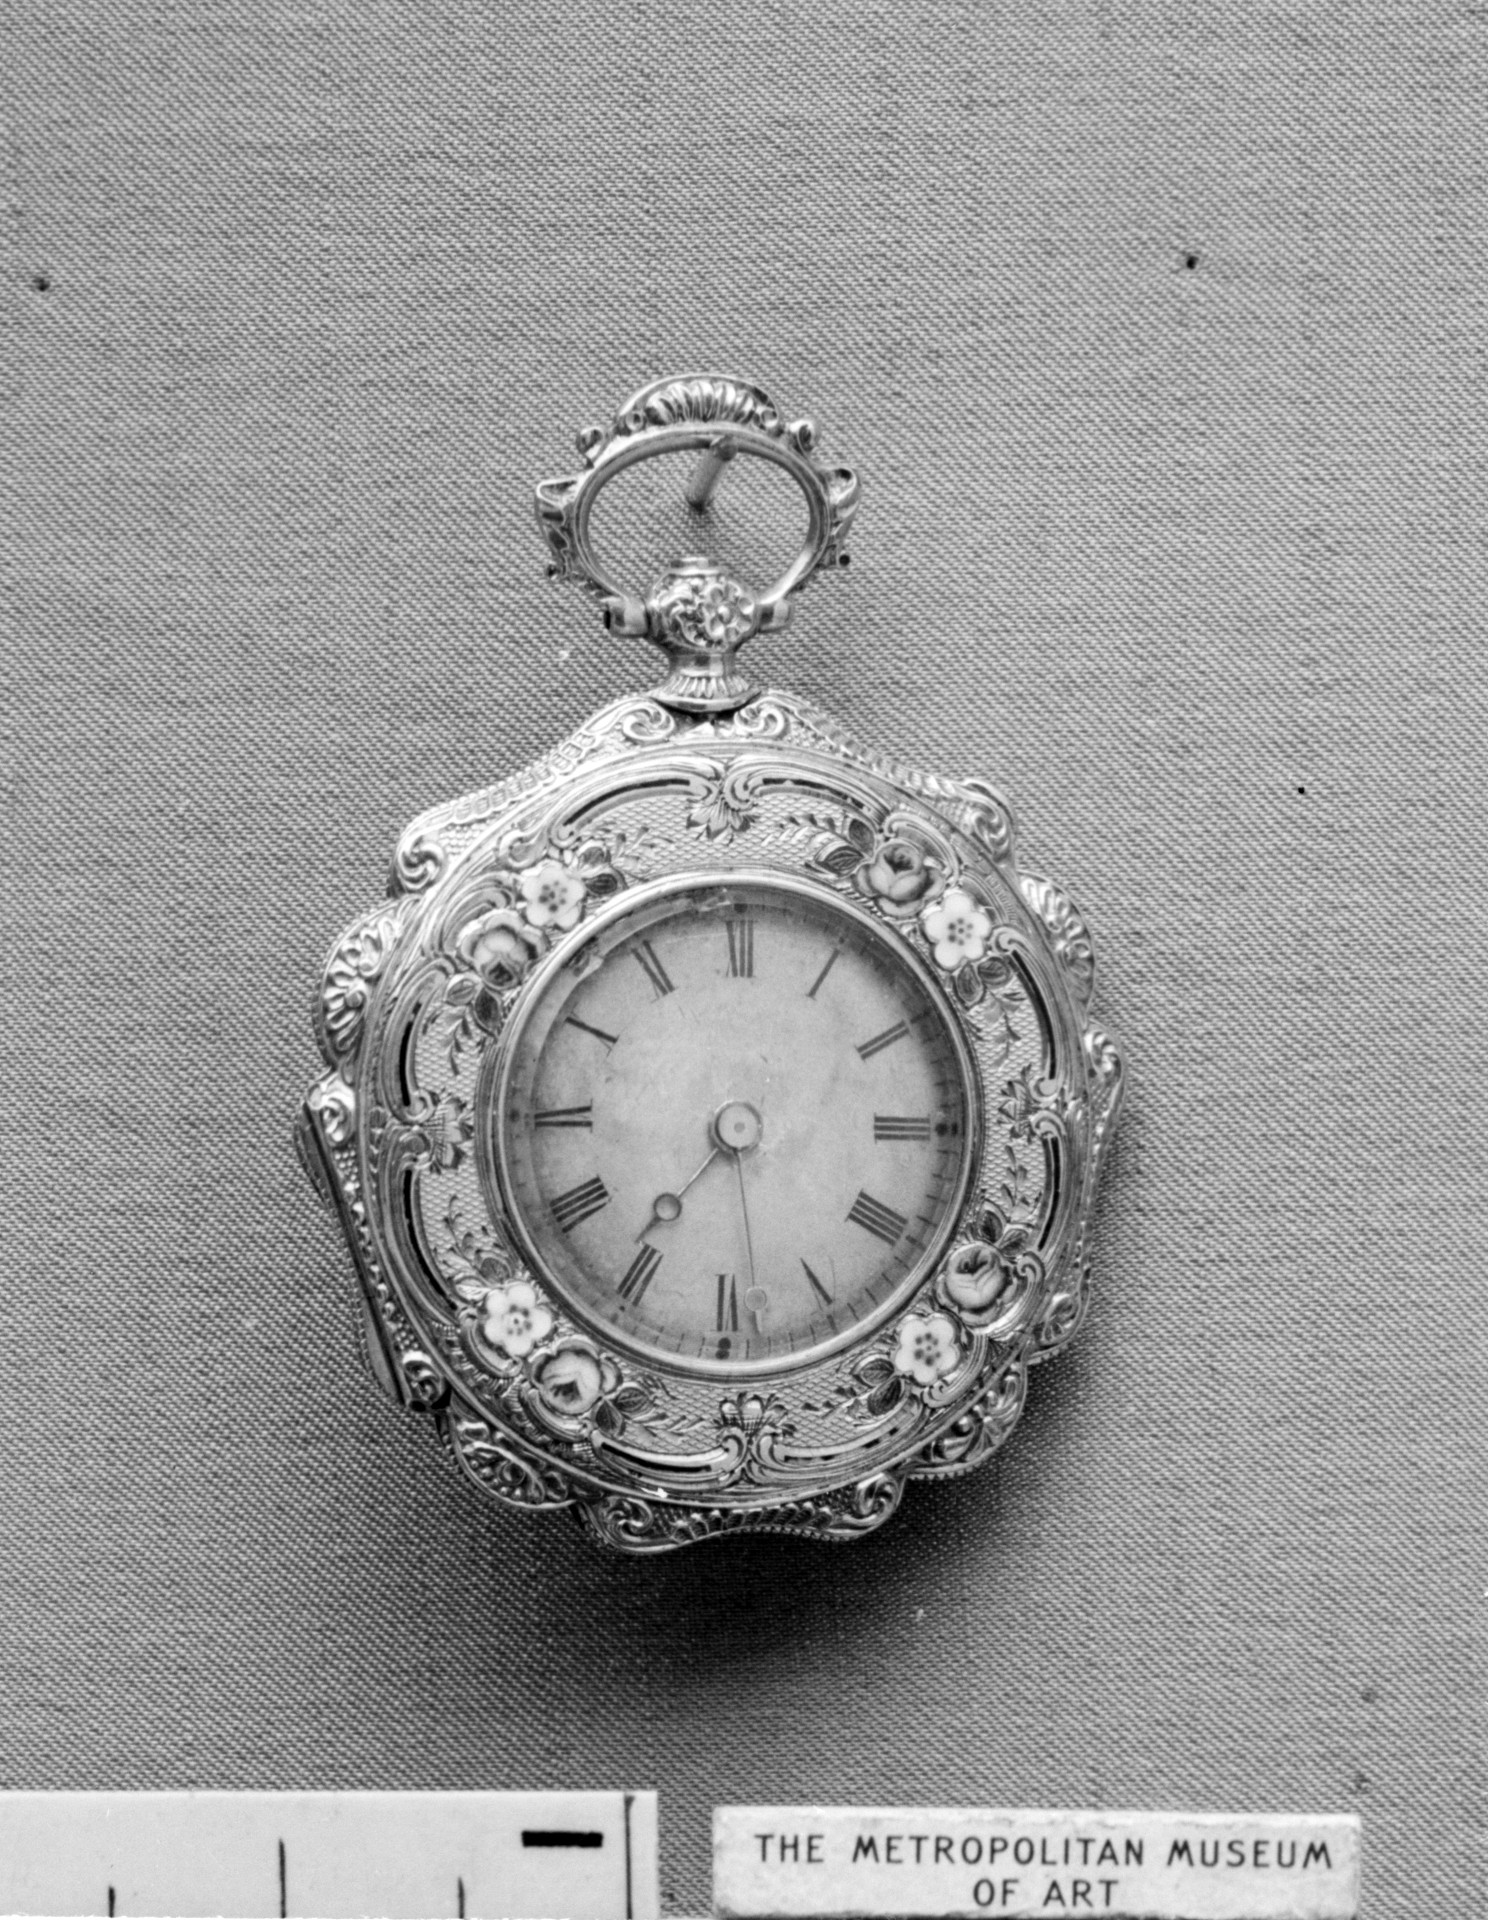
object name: watch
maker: auguste bergeon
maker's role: maker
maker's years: 1800-1900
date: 1801-1900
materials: enamel, gold, silver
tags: flowers,leaves